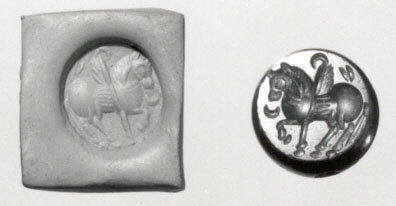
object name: stamp seal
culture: sasanian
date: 201-700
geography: iran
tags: pegasus